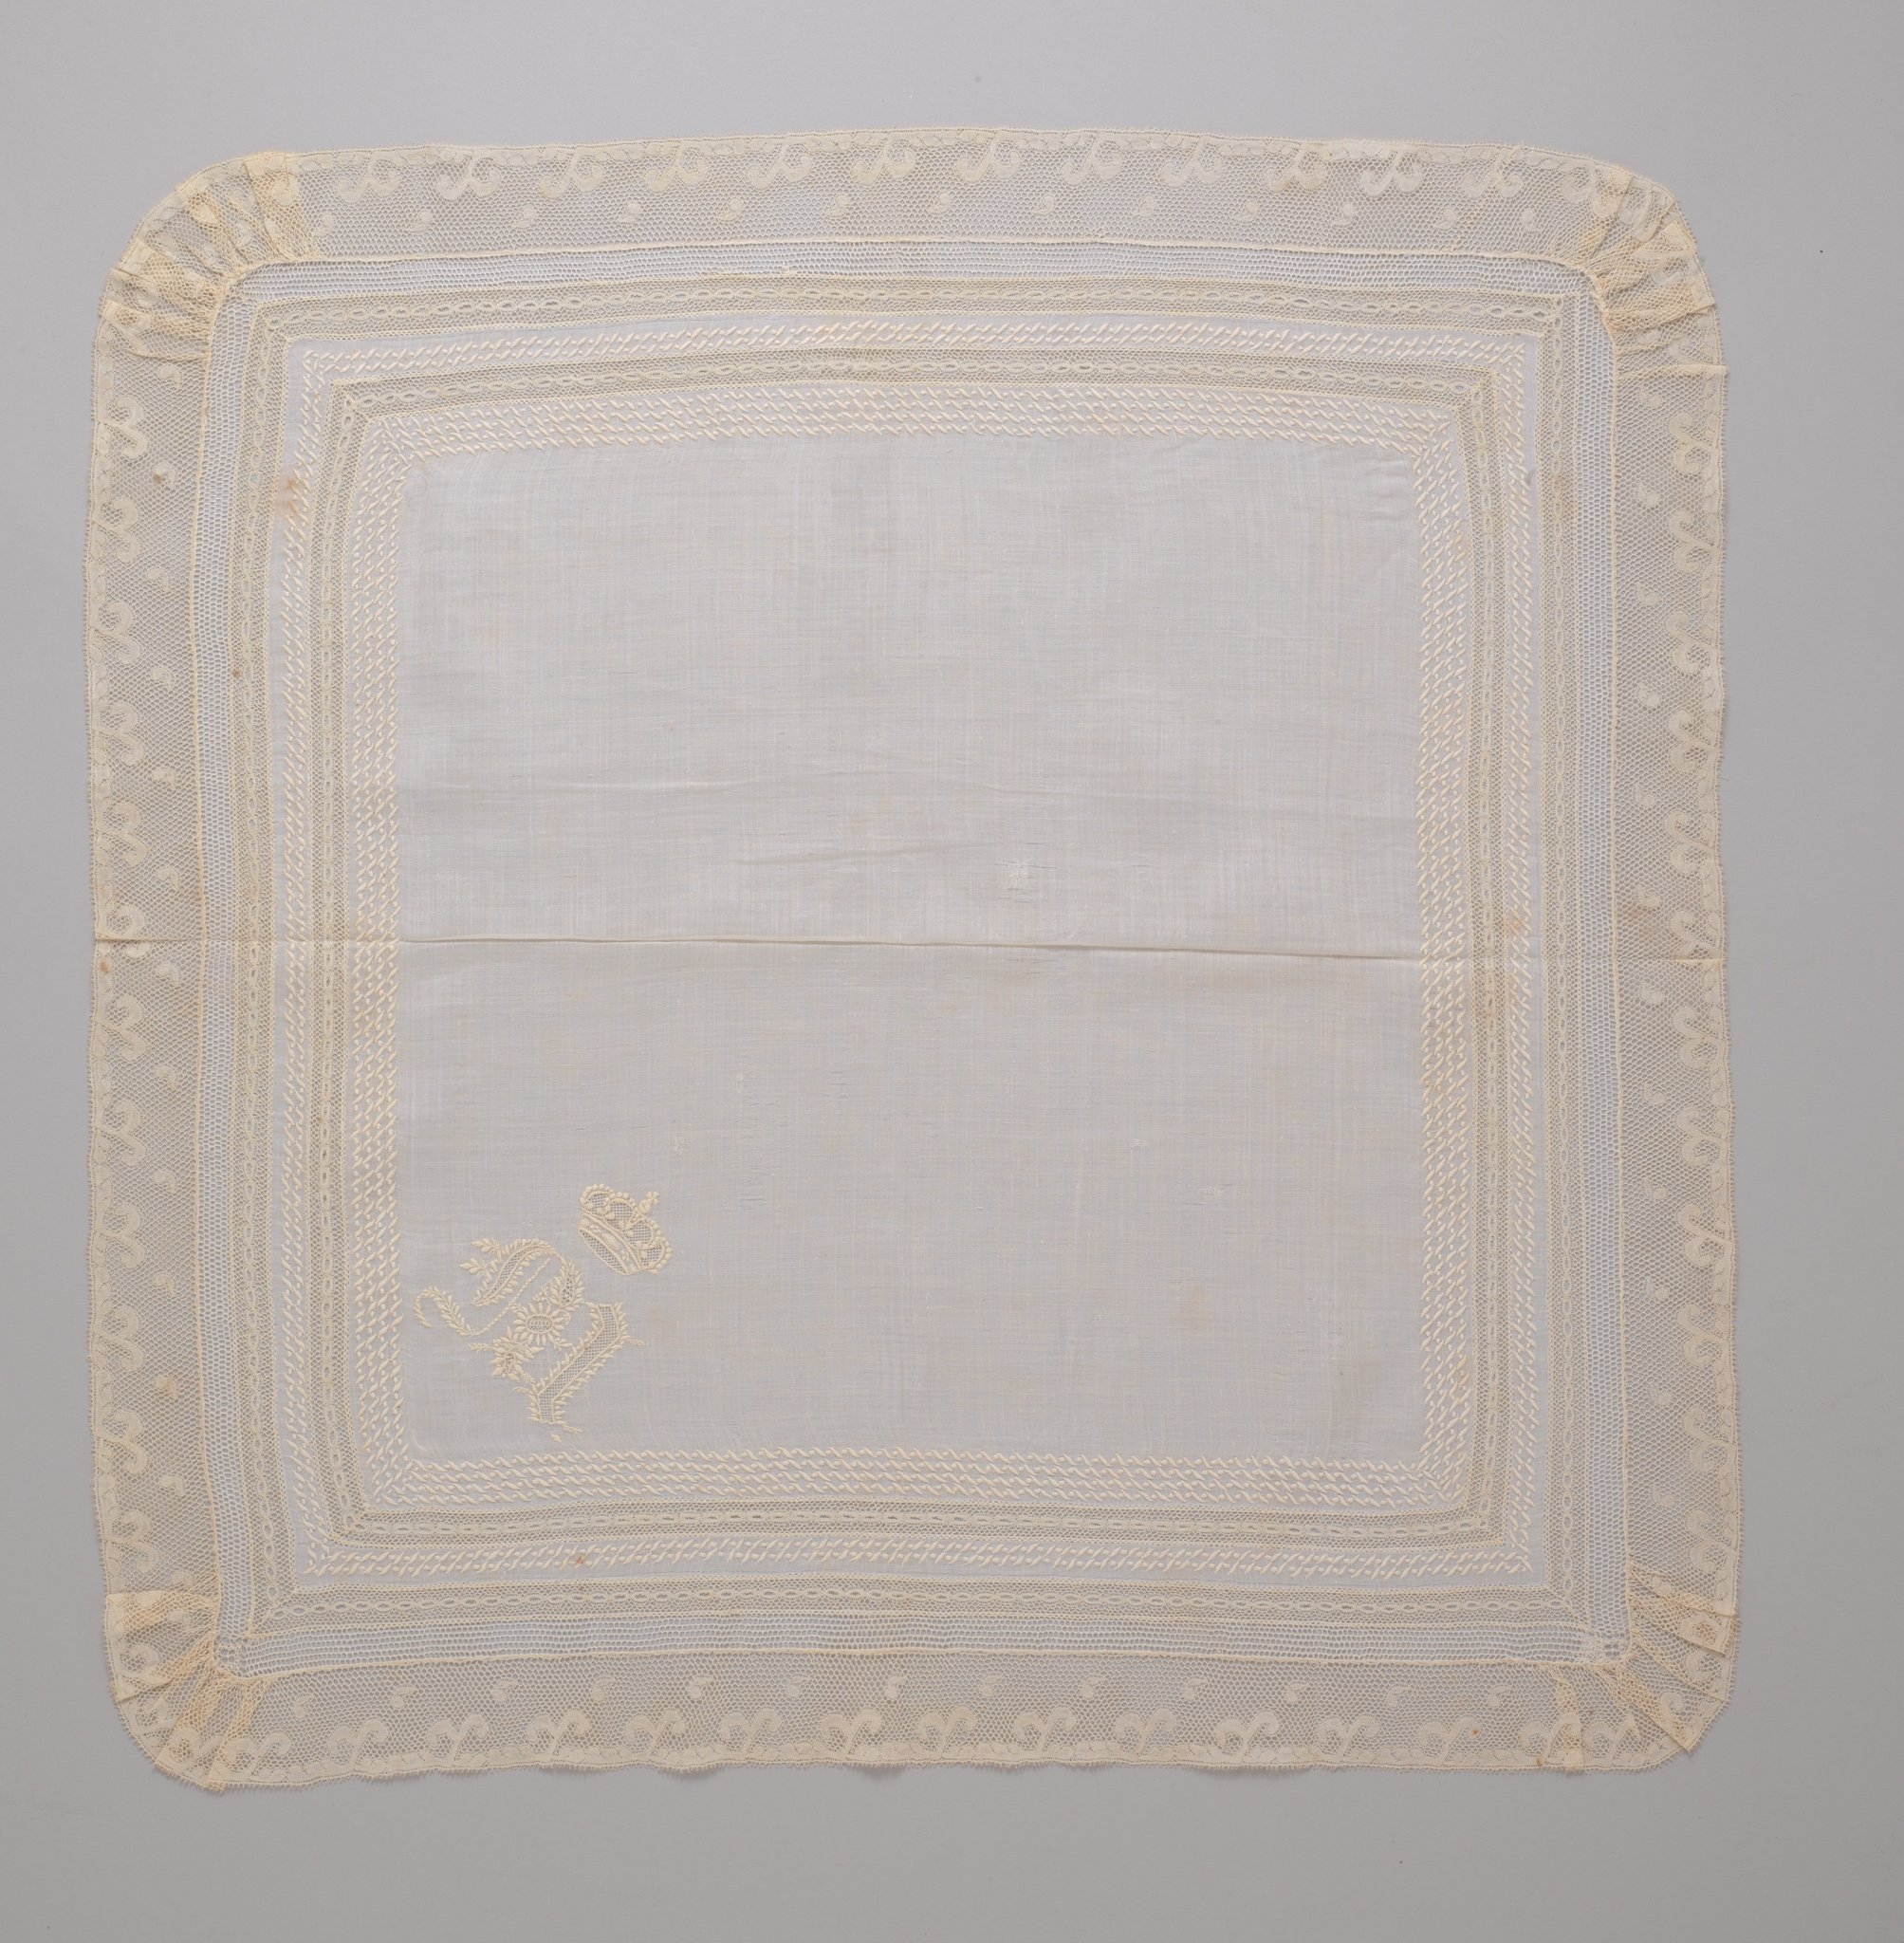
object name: handkerchief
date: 1840-1880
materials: cotton